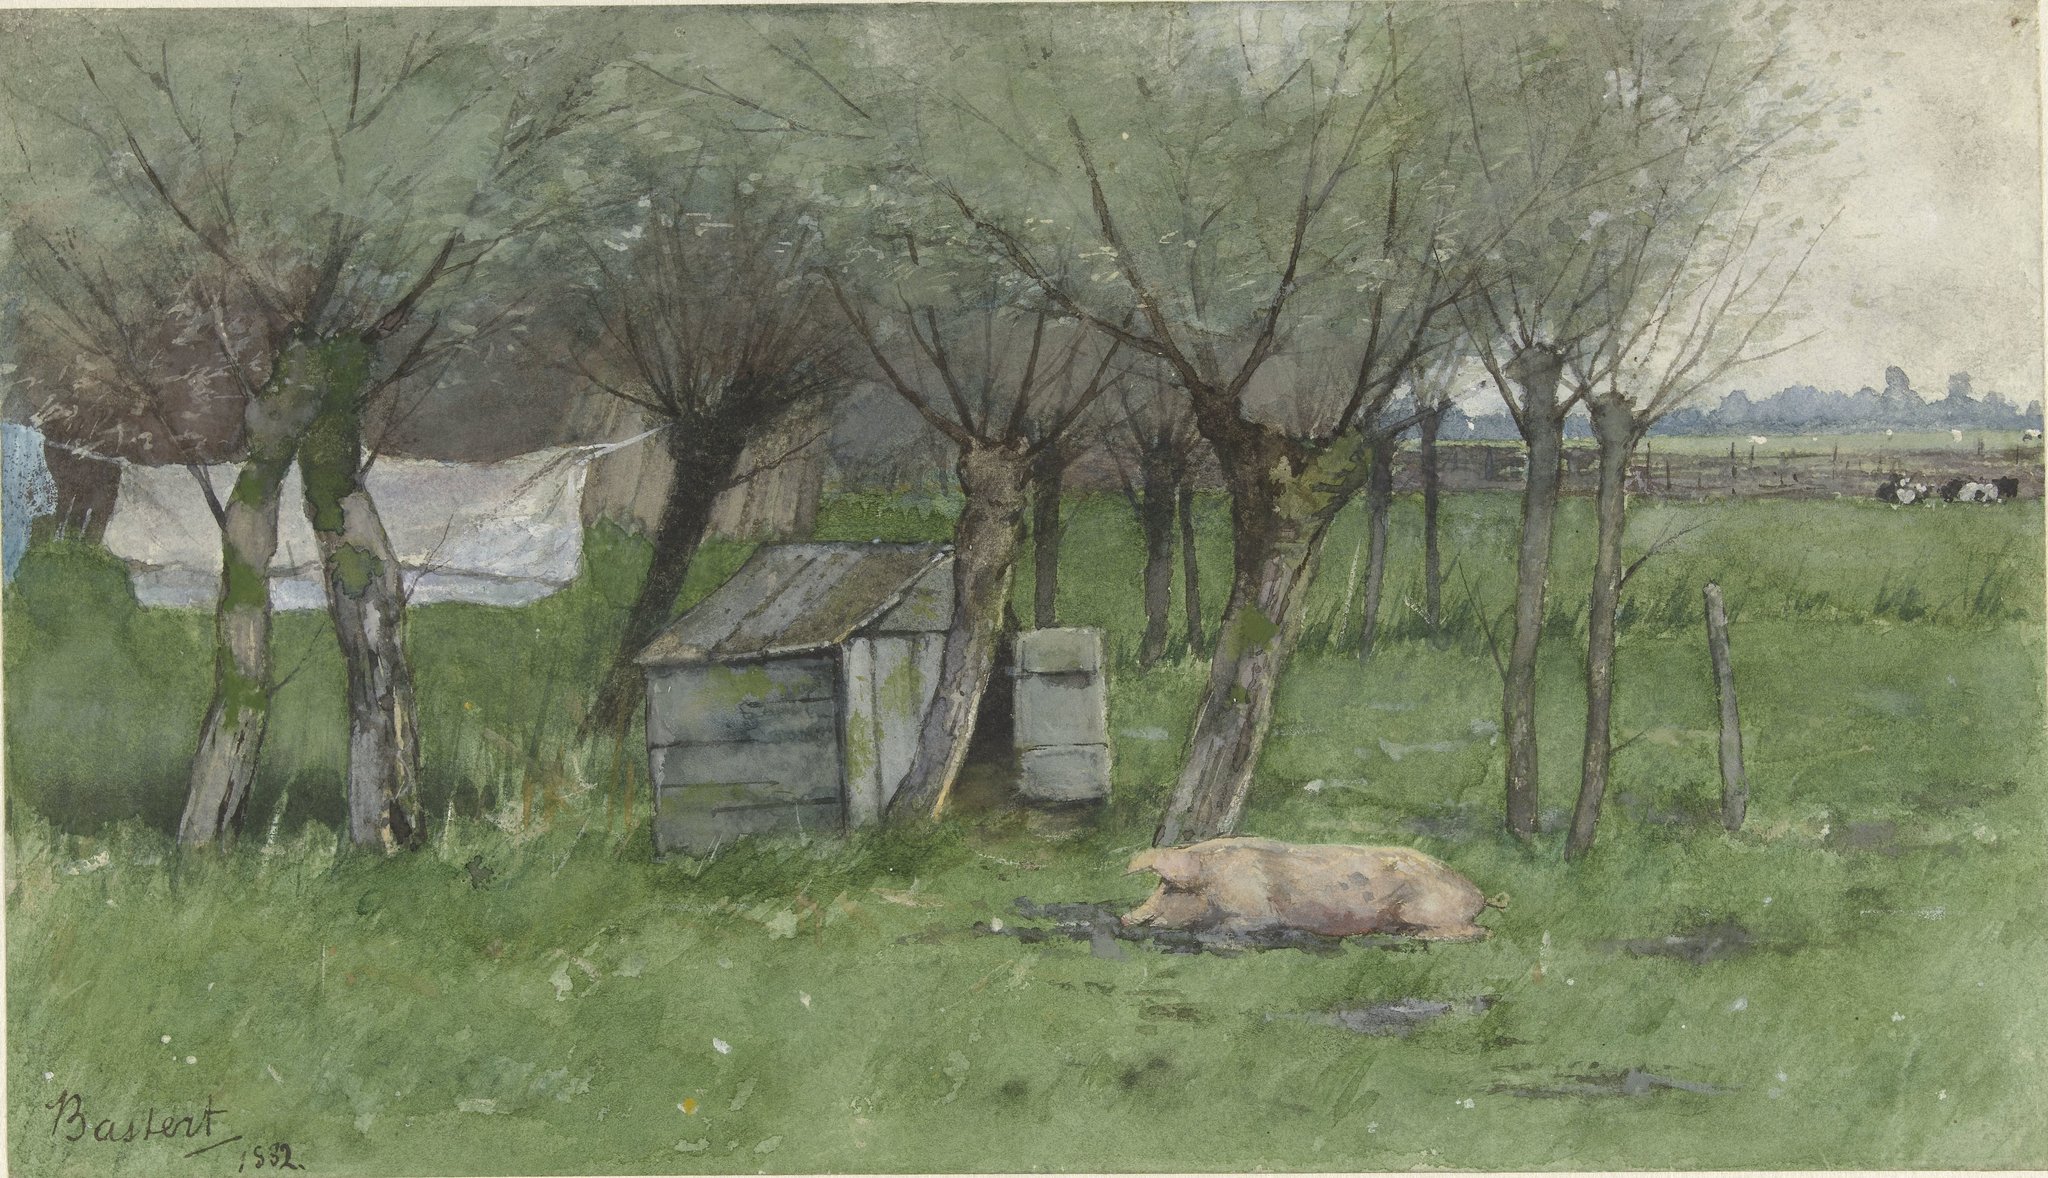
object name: watercolor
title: Boerenerf met liggend varken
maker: nicolaas bastert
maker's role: draughtsman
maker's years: 1854-1939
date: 1882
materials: paper, watercolor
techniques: brush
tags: pig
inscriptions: date: ‘1882’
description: Boerenerf met liggend varken bij een hok onder de wilgen.